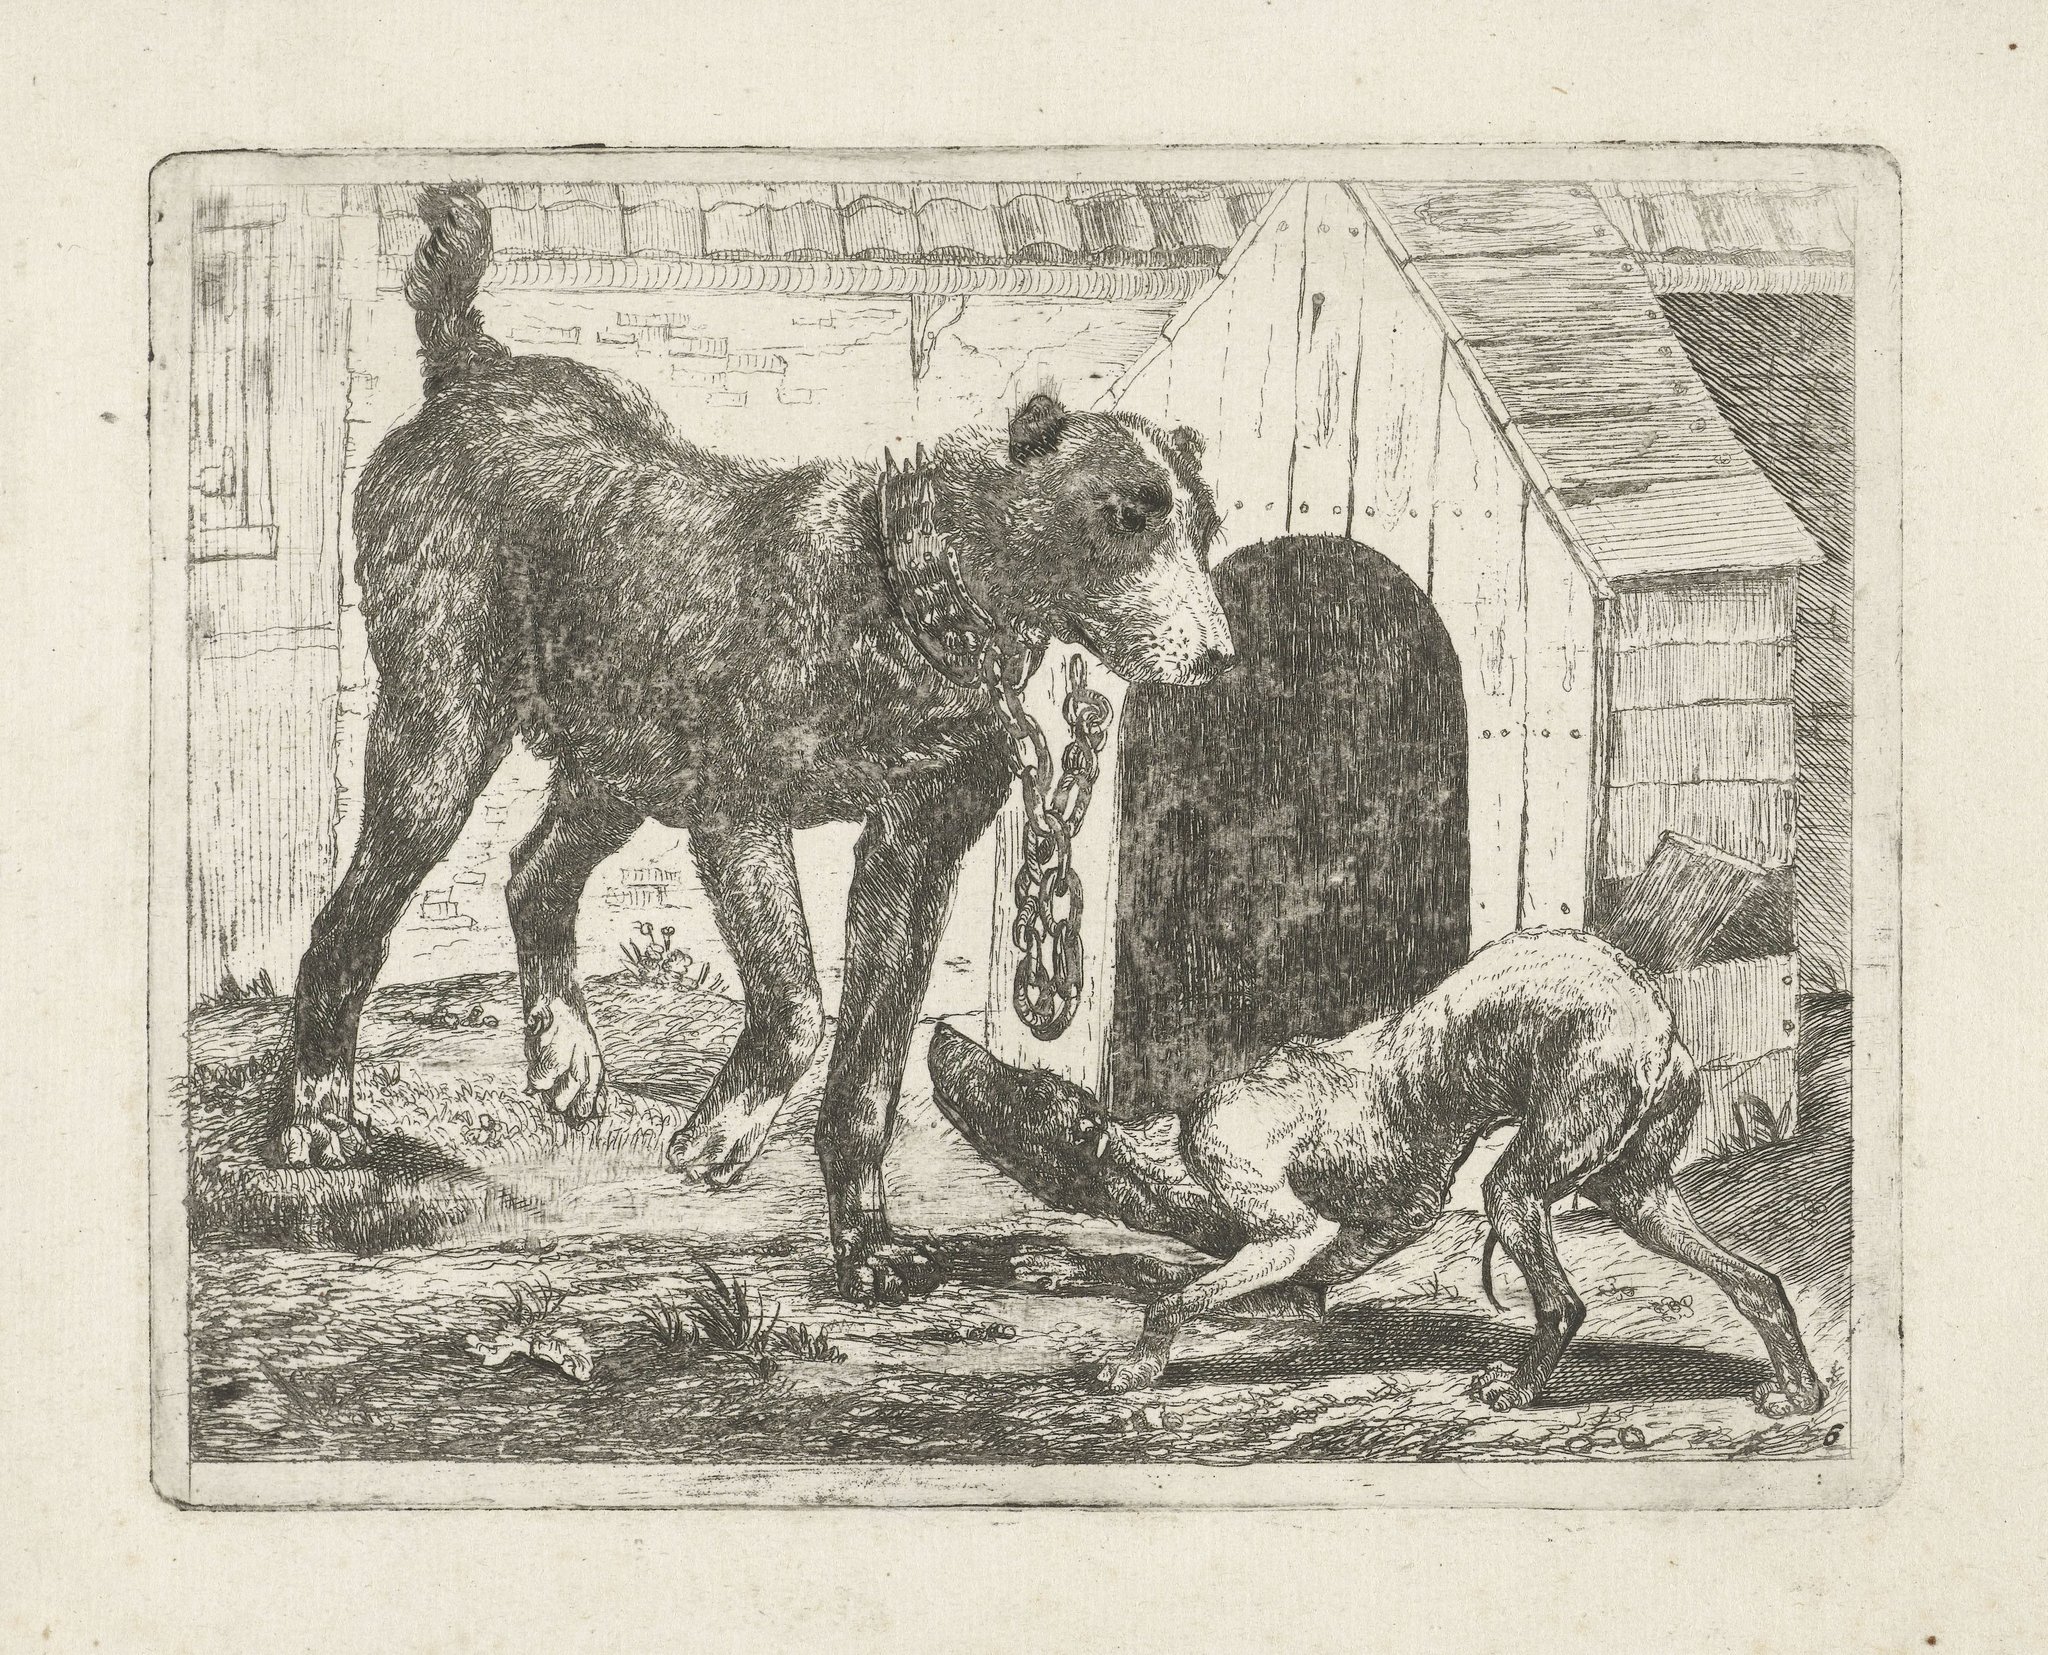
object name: print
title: Hond aan een ketting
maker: pauwels van hillegaert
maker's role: painter, print maker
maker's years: 1596-1658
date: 1654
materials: paper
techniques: etching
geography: amsterdam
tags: dog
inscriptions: collector's mark: Lugt 240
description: Twee honden waarvan een aan een ketting voor een hondenhok. Zesde prent van een serie van acht prenten met voorstellingen van honden.